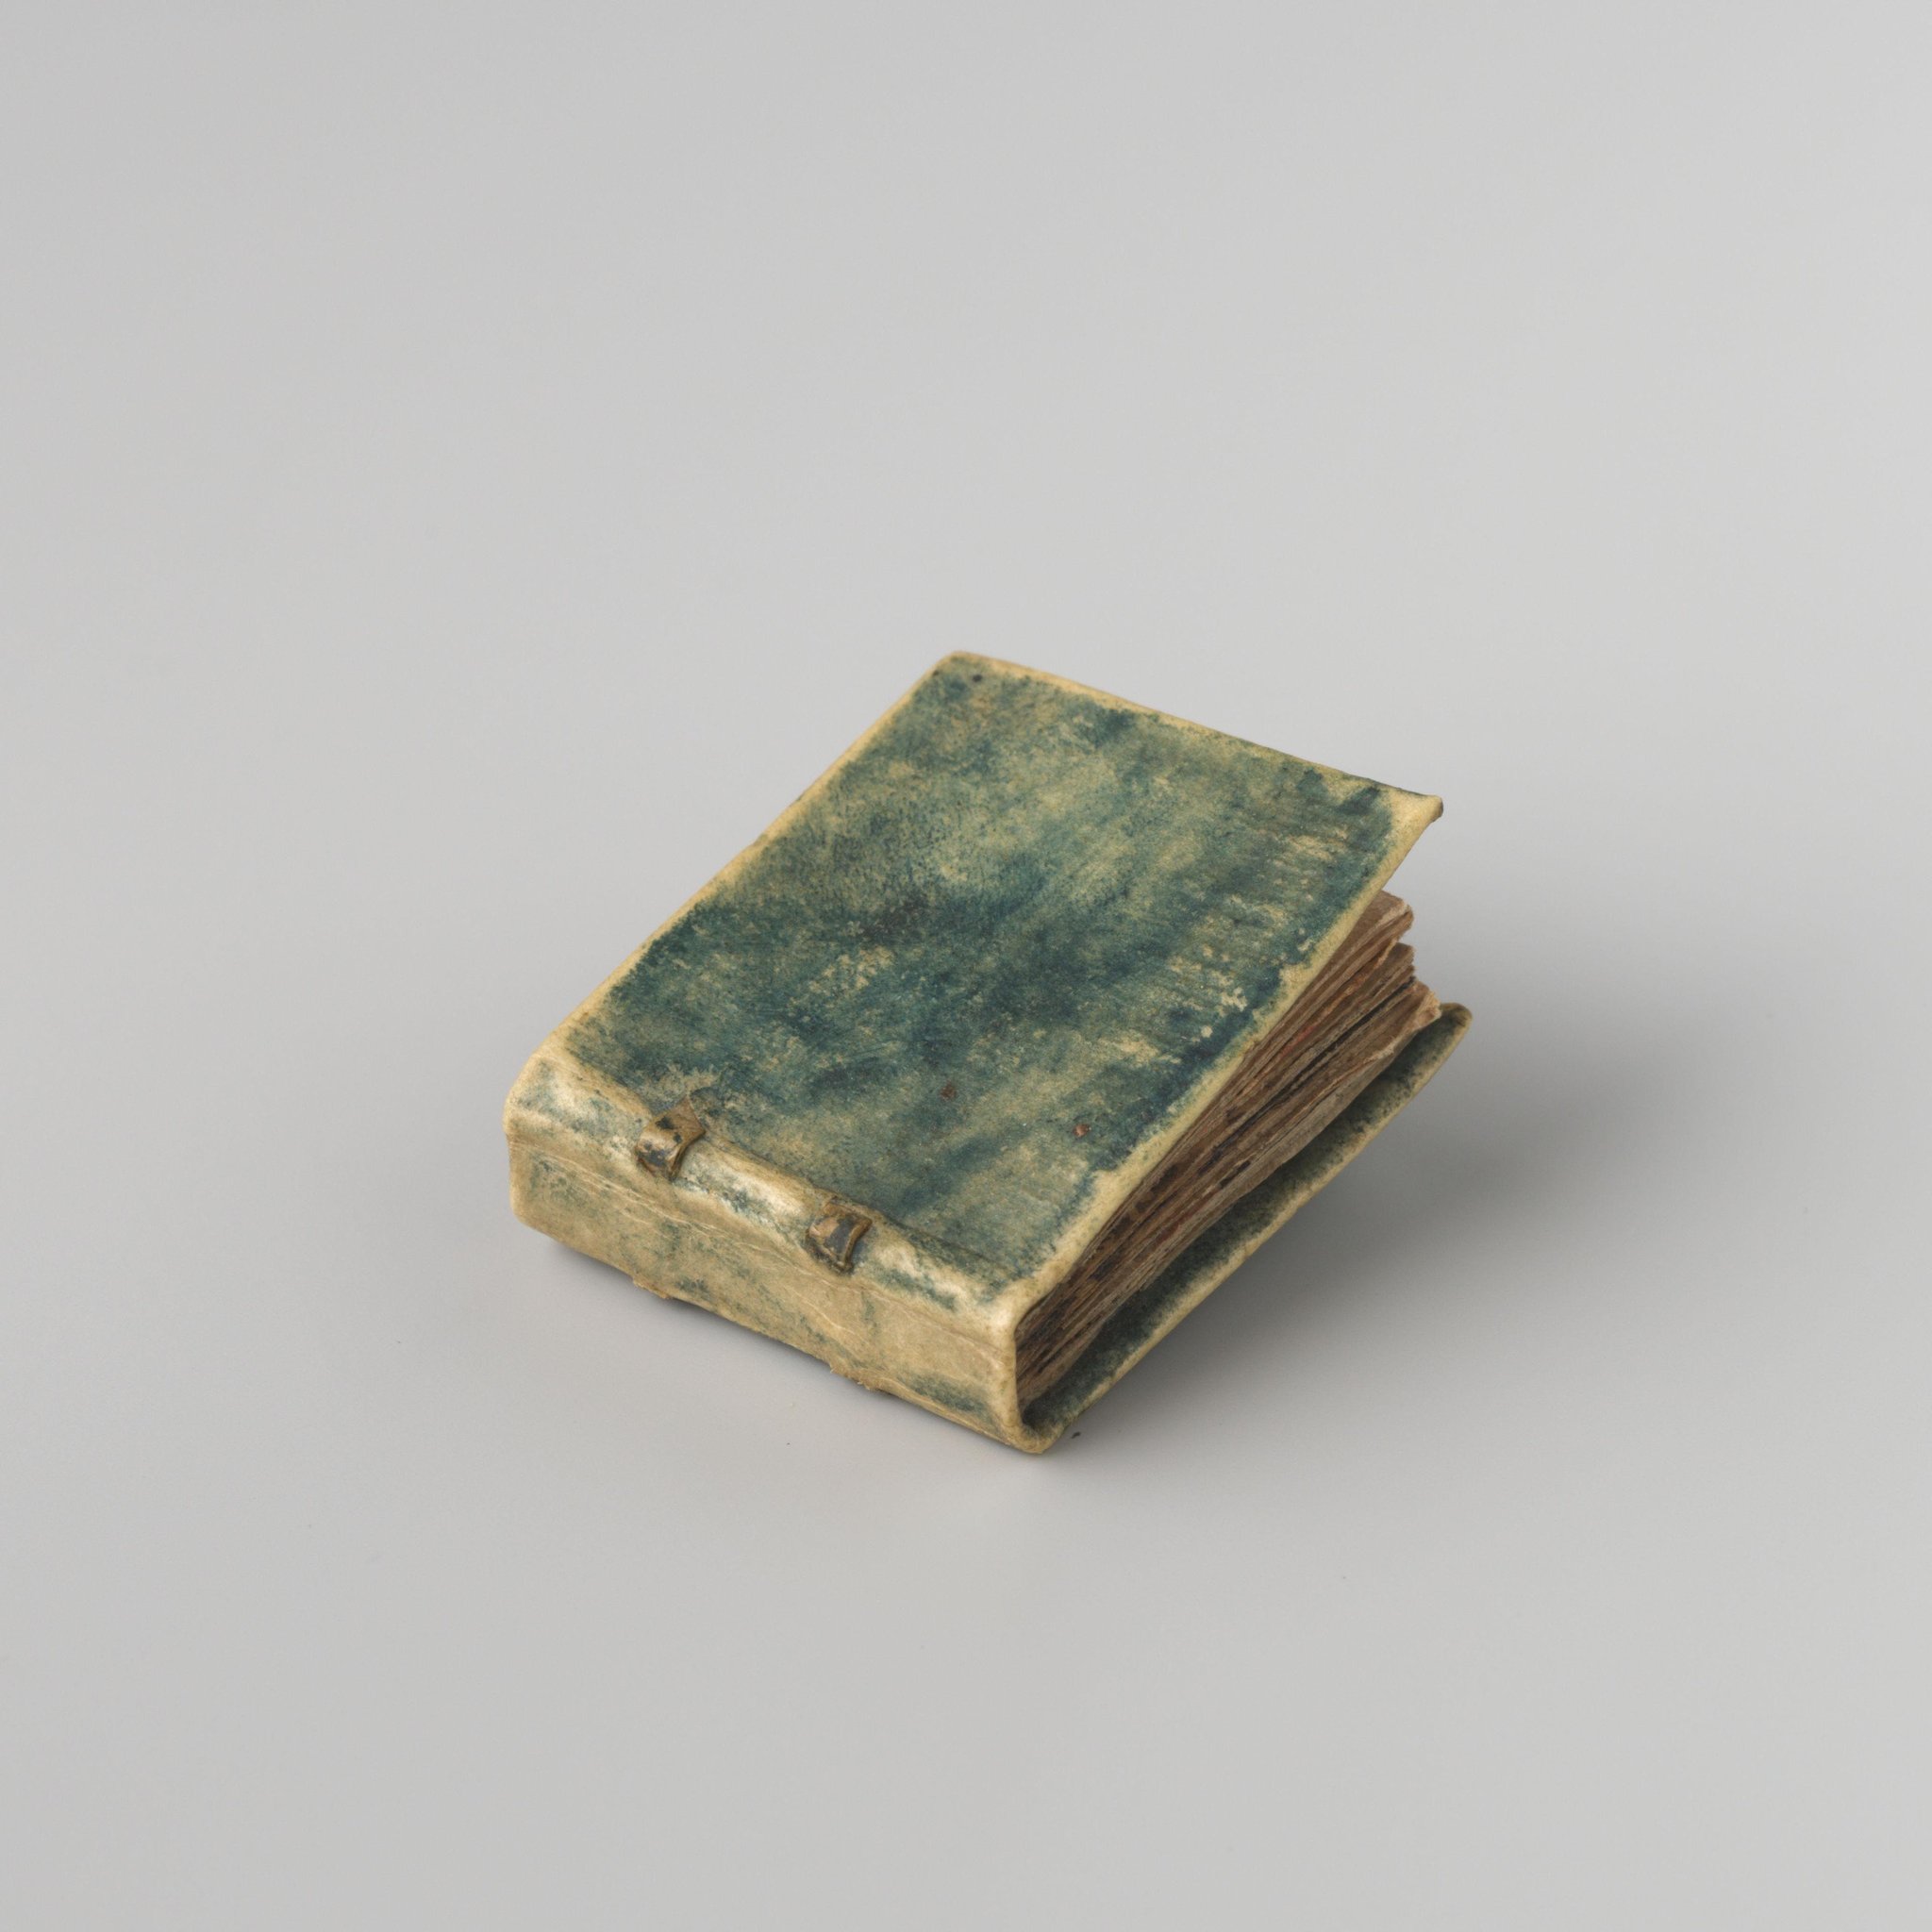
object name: book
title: Boek met stads- en tuingezichten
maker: Anonymous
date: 1690-1710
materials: leather, paper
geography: amsterdam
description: Boek met stads- en tuingezichten. Ingebonden in blauw gekleurd perkament.